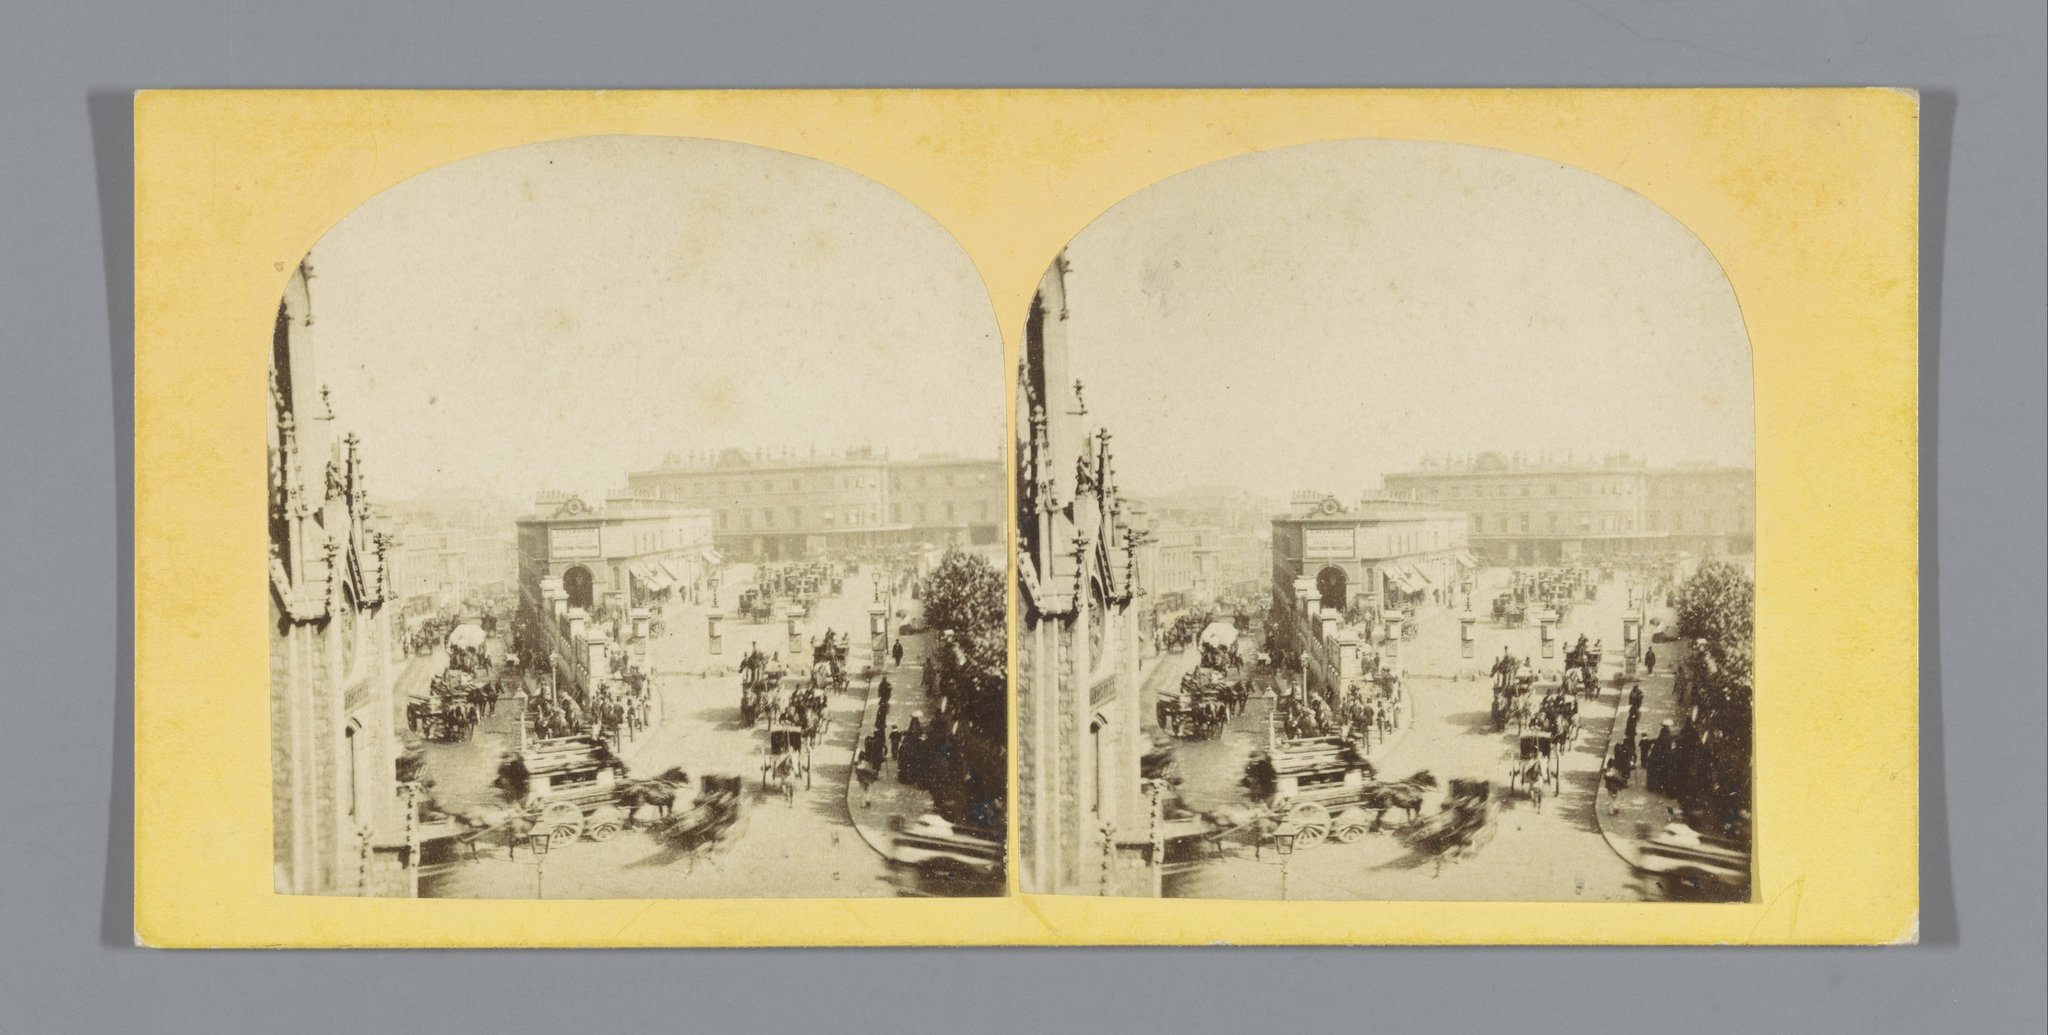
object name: stereograph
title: Treinstation bij de London Bridge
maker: Anonymous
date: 1850-1880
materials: cardboard, photographic support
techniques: albumen print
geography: london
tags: four-wheeled, animal-drawn vehicle, e.g.: cab, carriage, coach, railway, train, london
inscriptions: inscription: ‘London Bridge Railway Station’